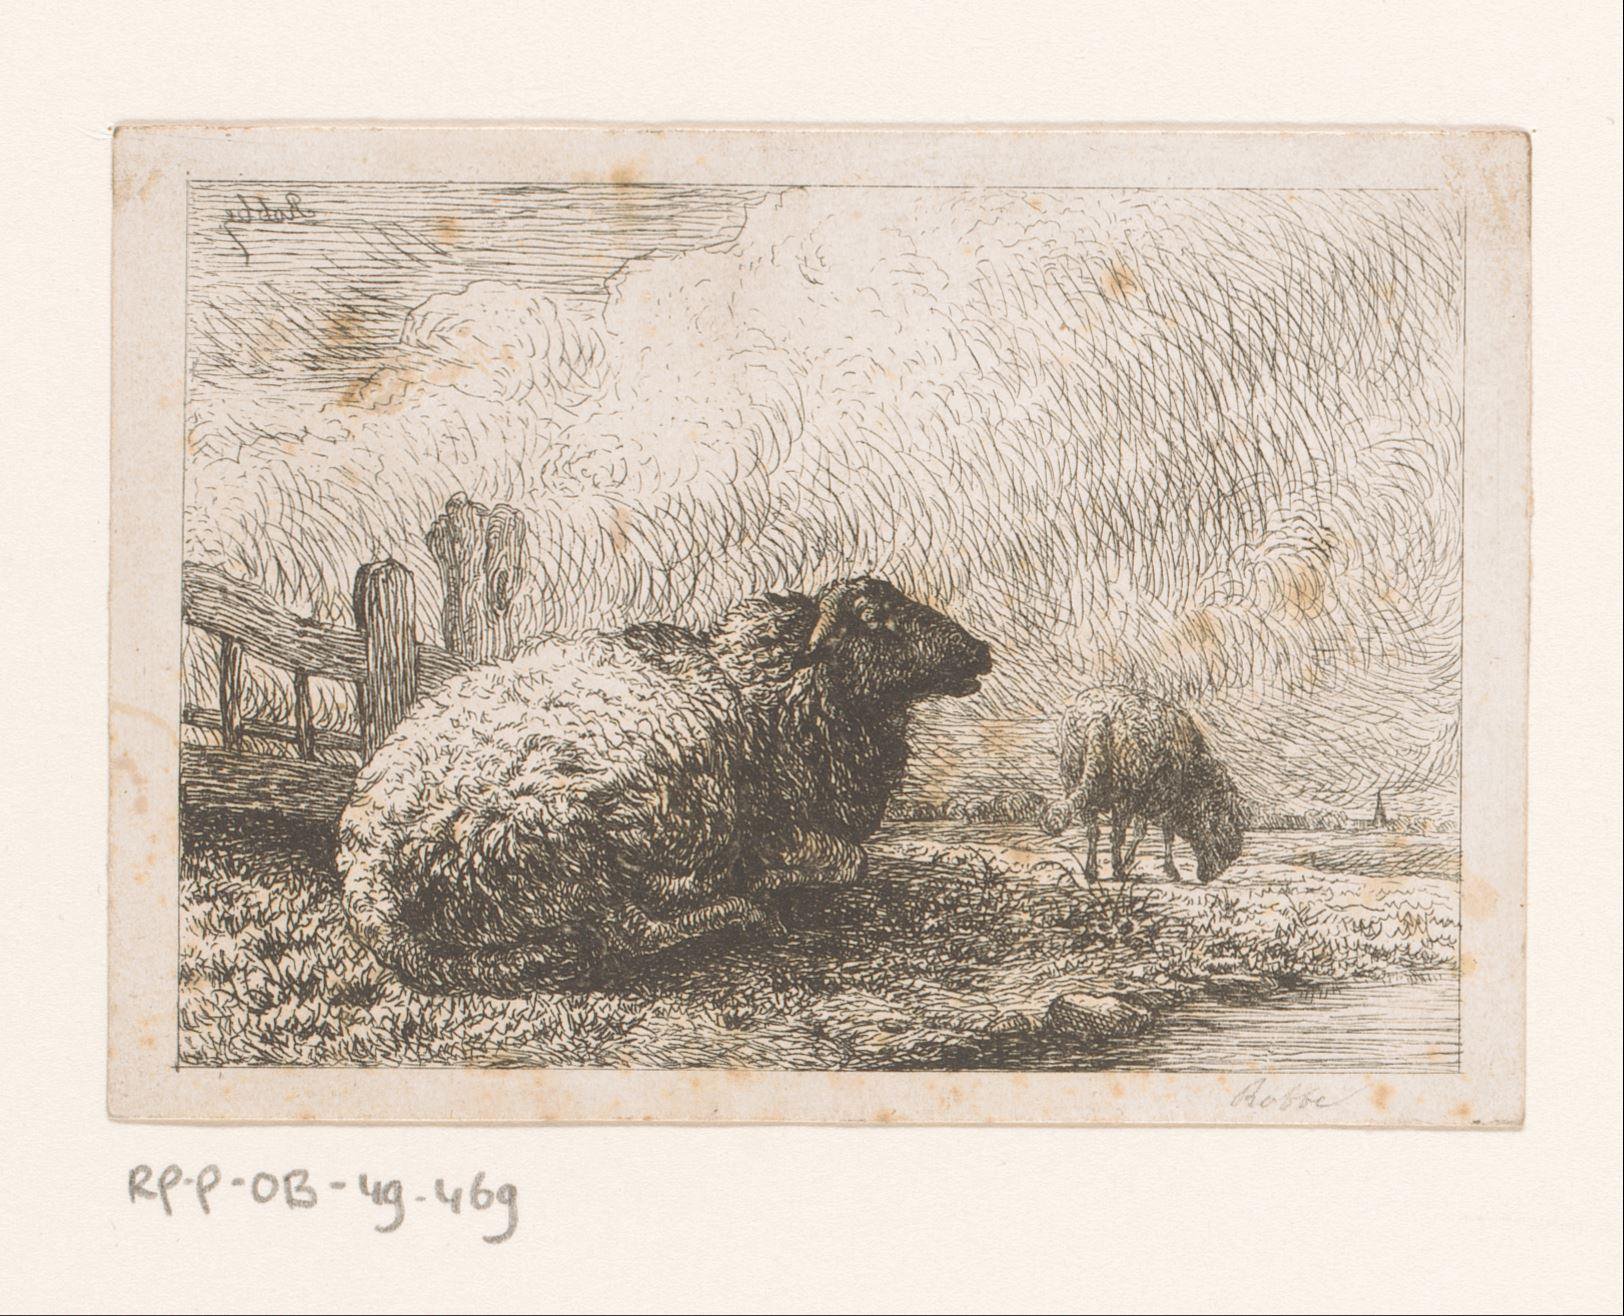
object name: print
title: Twee schapen in een weide aan het water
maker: louis robbe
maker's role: print maker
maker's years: 1806-1887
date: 1816-1879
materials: paper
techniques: etching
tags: meadow, pasture, sheep